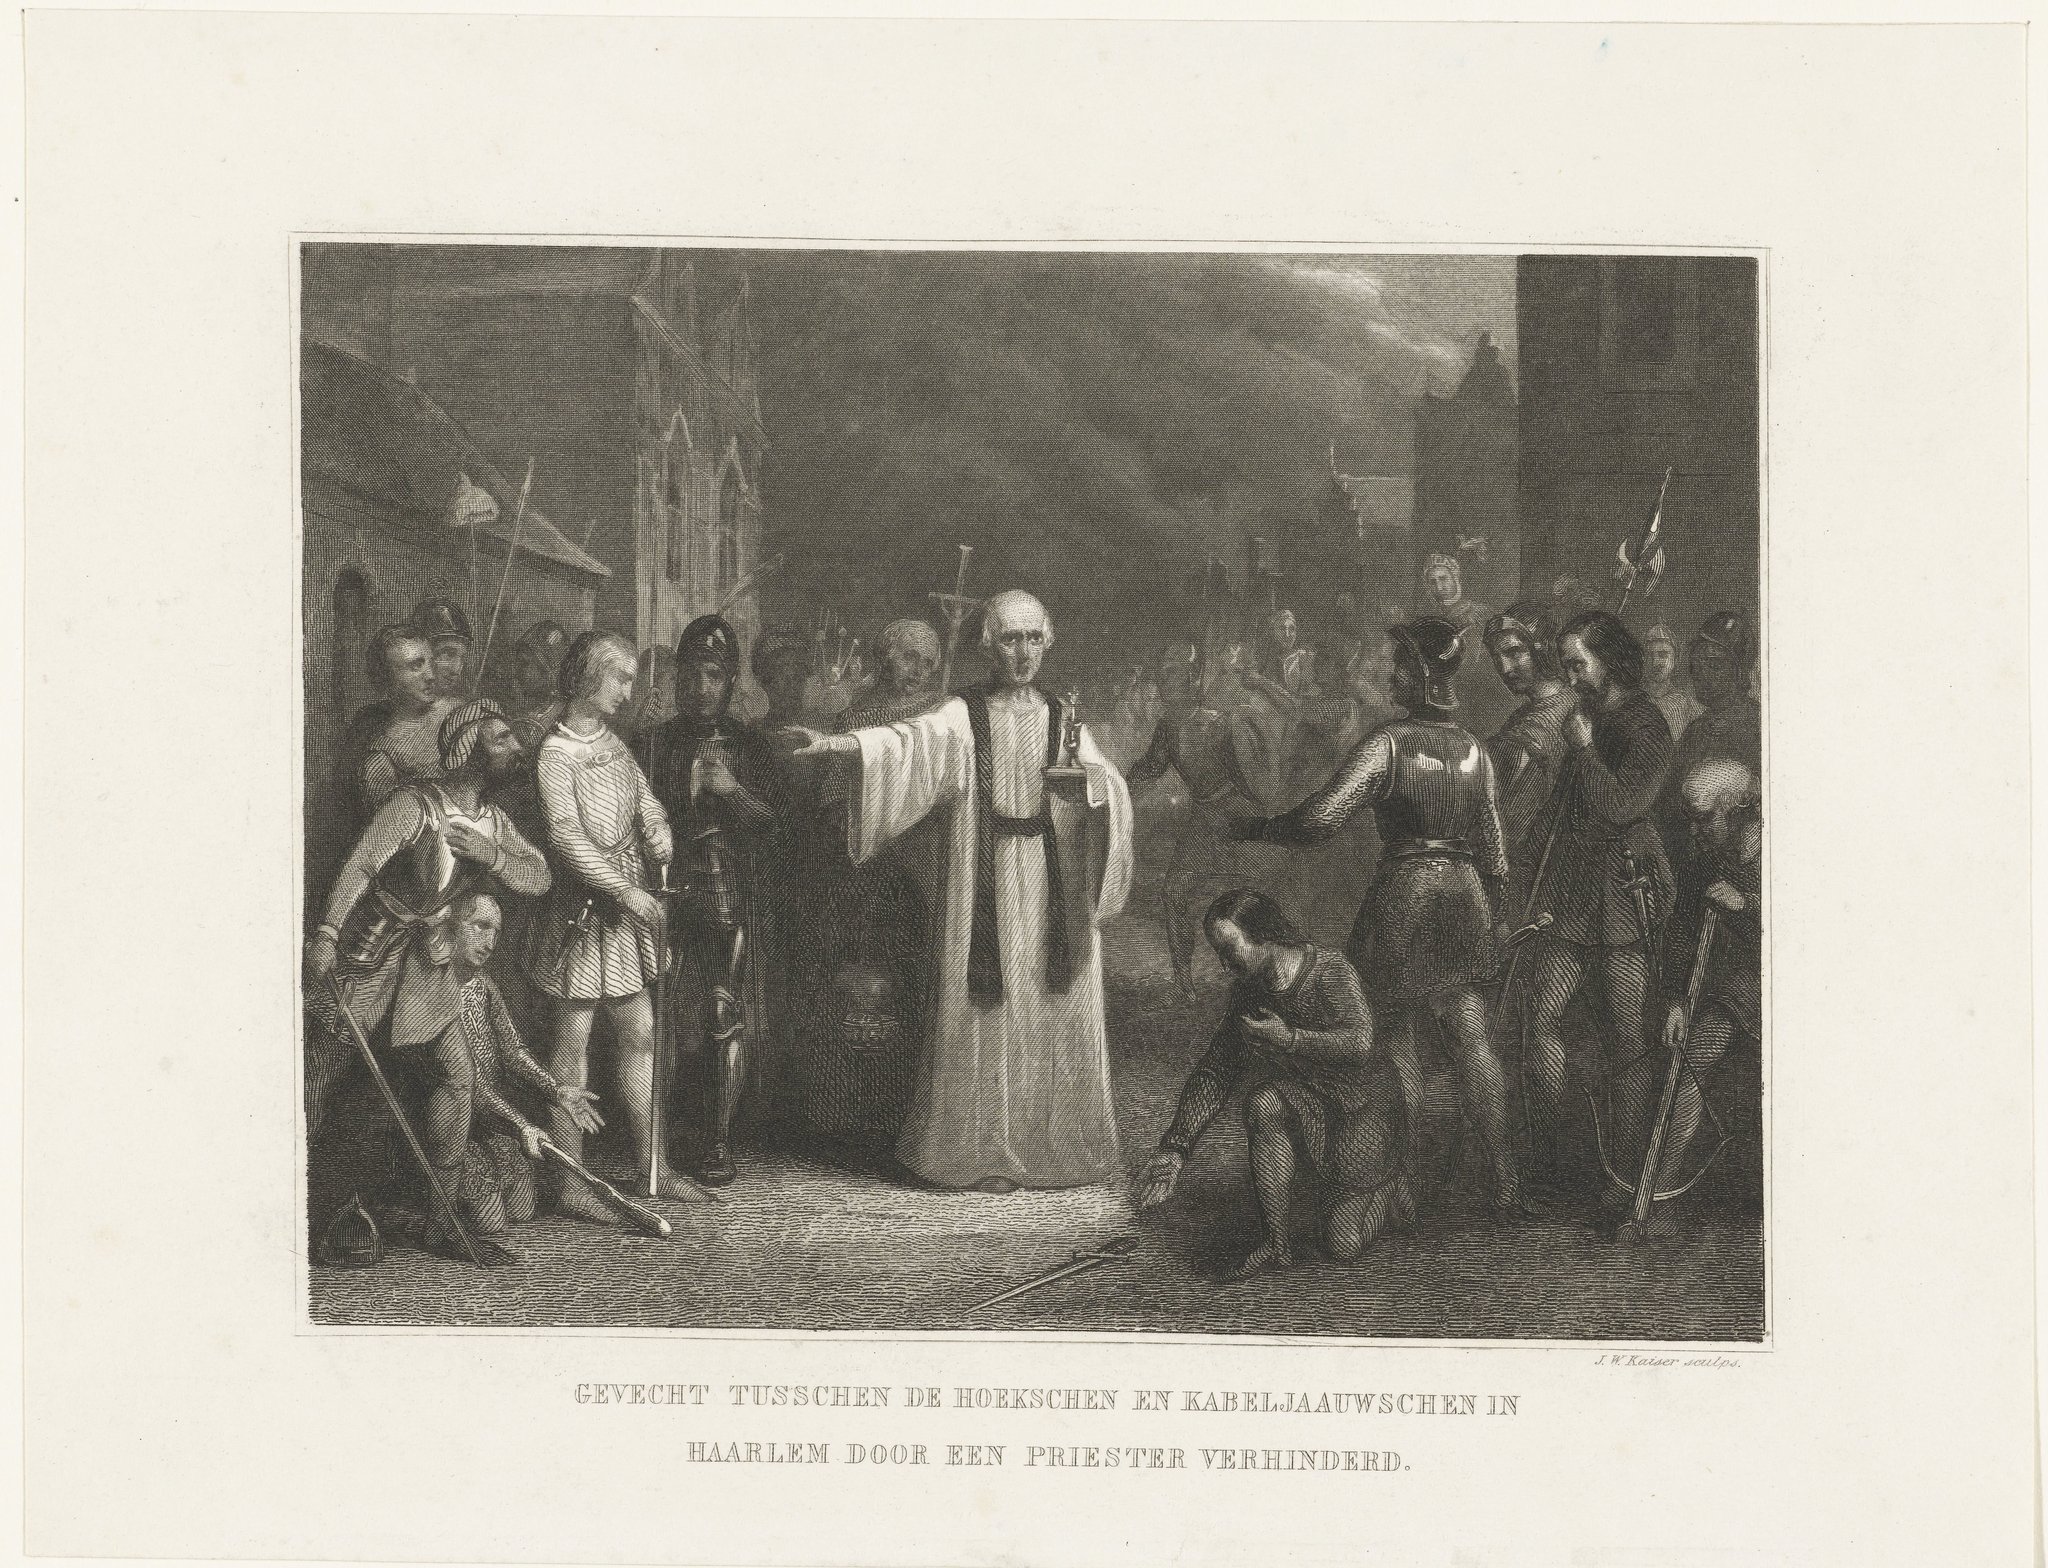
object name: print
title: Gevecht tussen de Hoeken en Kabeljauwen in Haarlem door een priester verhinderd, 1444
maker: johann wilhelm kaiser (i)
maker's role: draughtsman, print maker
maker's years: 1813-1900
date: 1844-1846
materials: paper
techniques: engraving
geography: netherlands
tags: haarlem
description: Gevecht tussen de Hoeken en Kabeljauwen in Haarlem door een priester verhinderd, 1444. De priester stelt zich op straat tussen de twee strijdende partijen op.